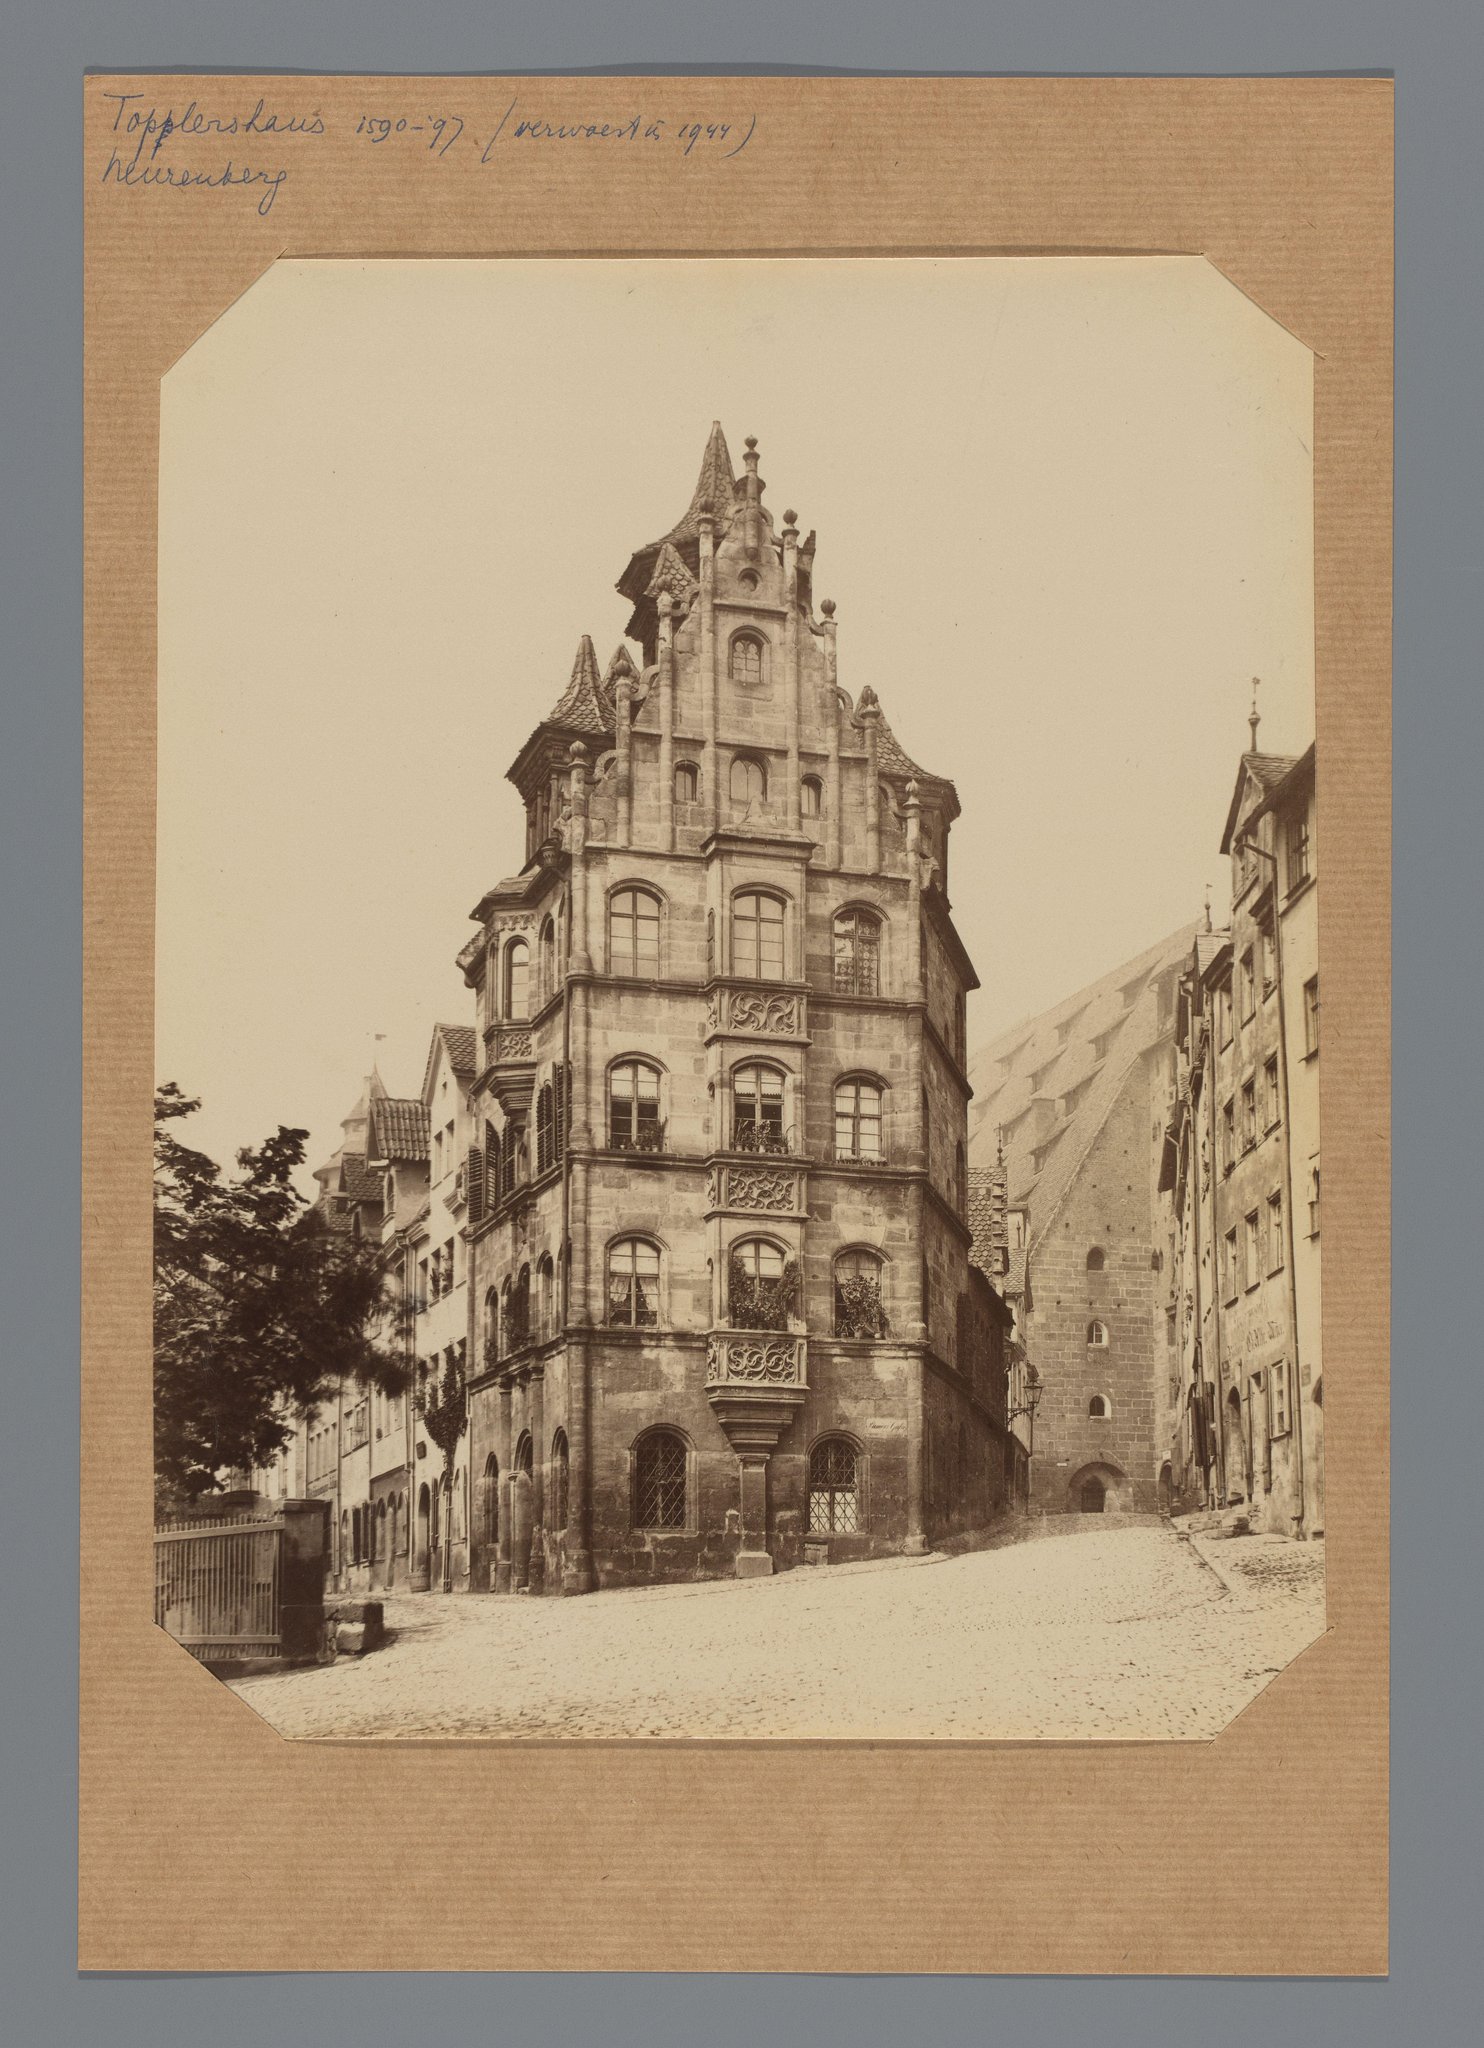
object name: photograph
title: Neurenberg, Topplershaus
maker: Anonymous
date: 1850-1890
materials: photographic support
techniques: albumen print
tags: neurenberg